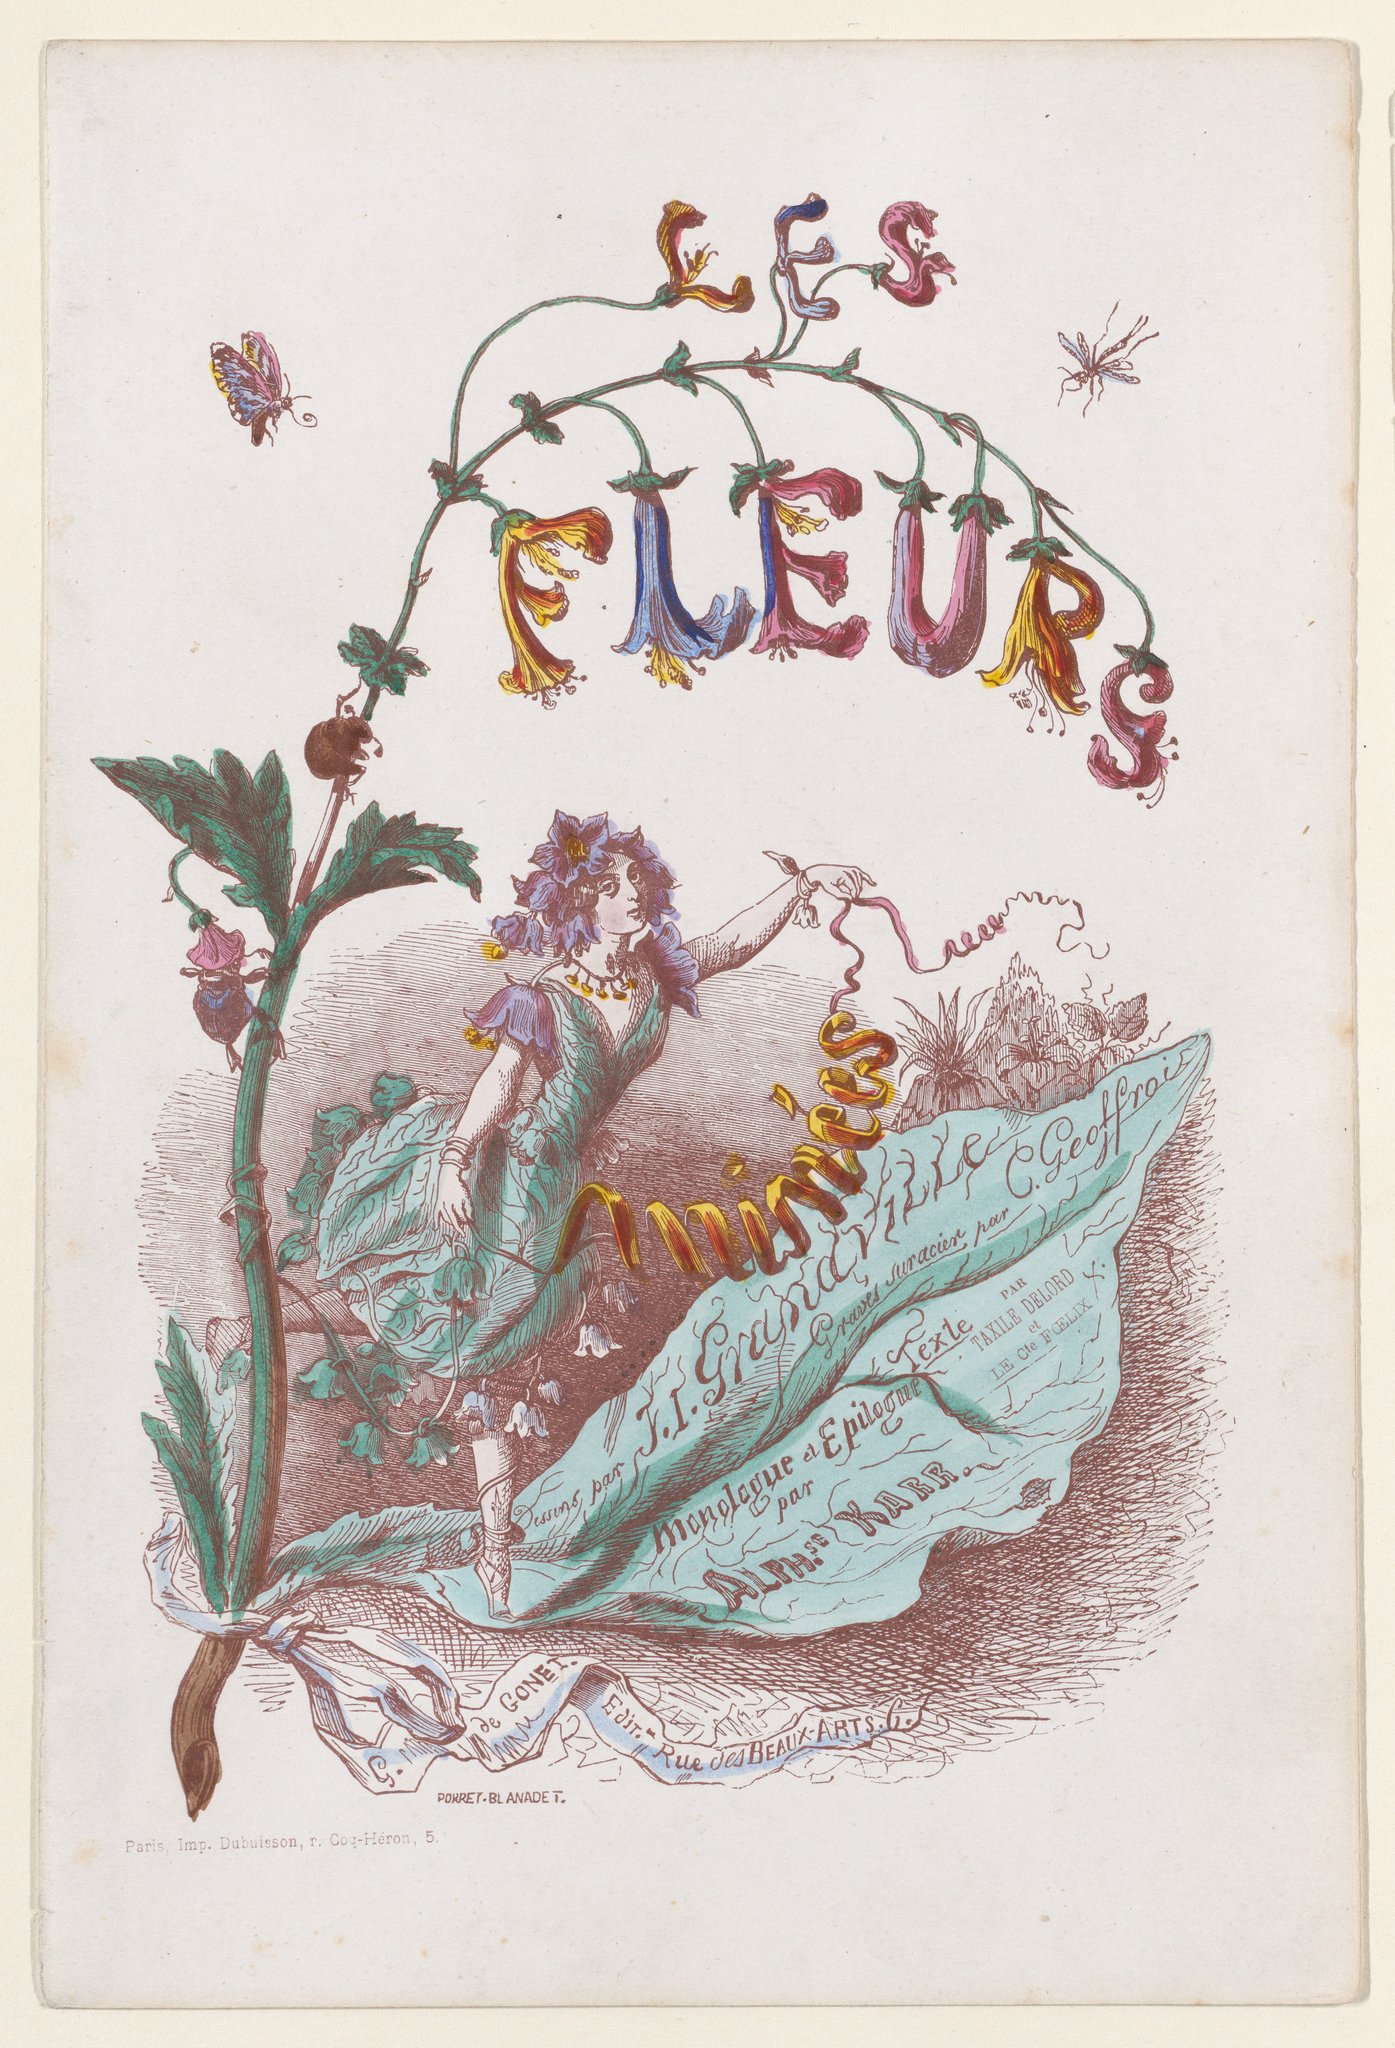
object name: print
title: Les Fleurs Animées, Title Page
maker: j. j. grandville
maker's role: designer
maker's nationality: french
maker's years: 1803-1847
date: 1847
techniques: hand coloring, engraving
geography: paris